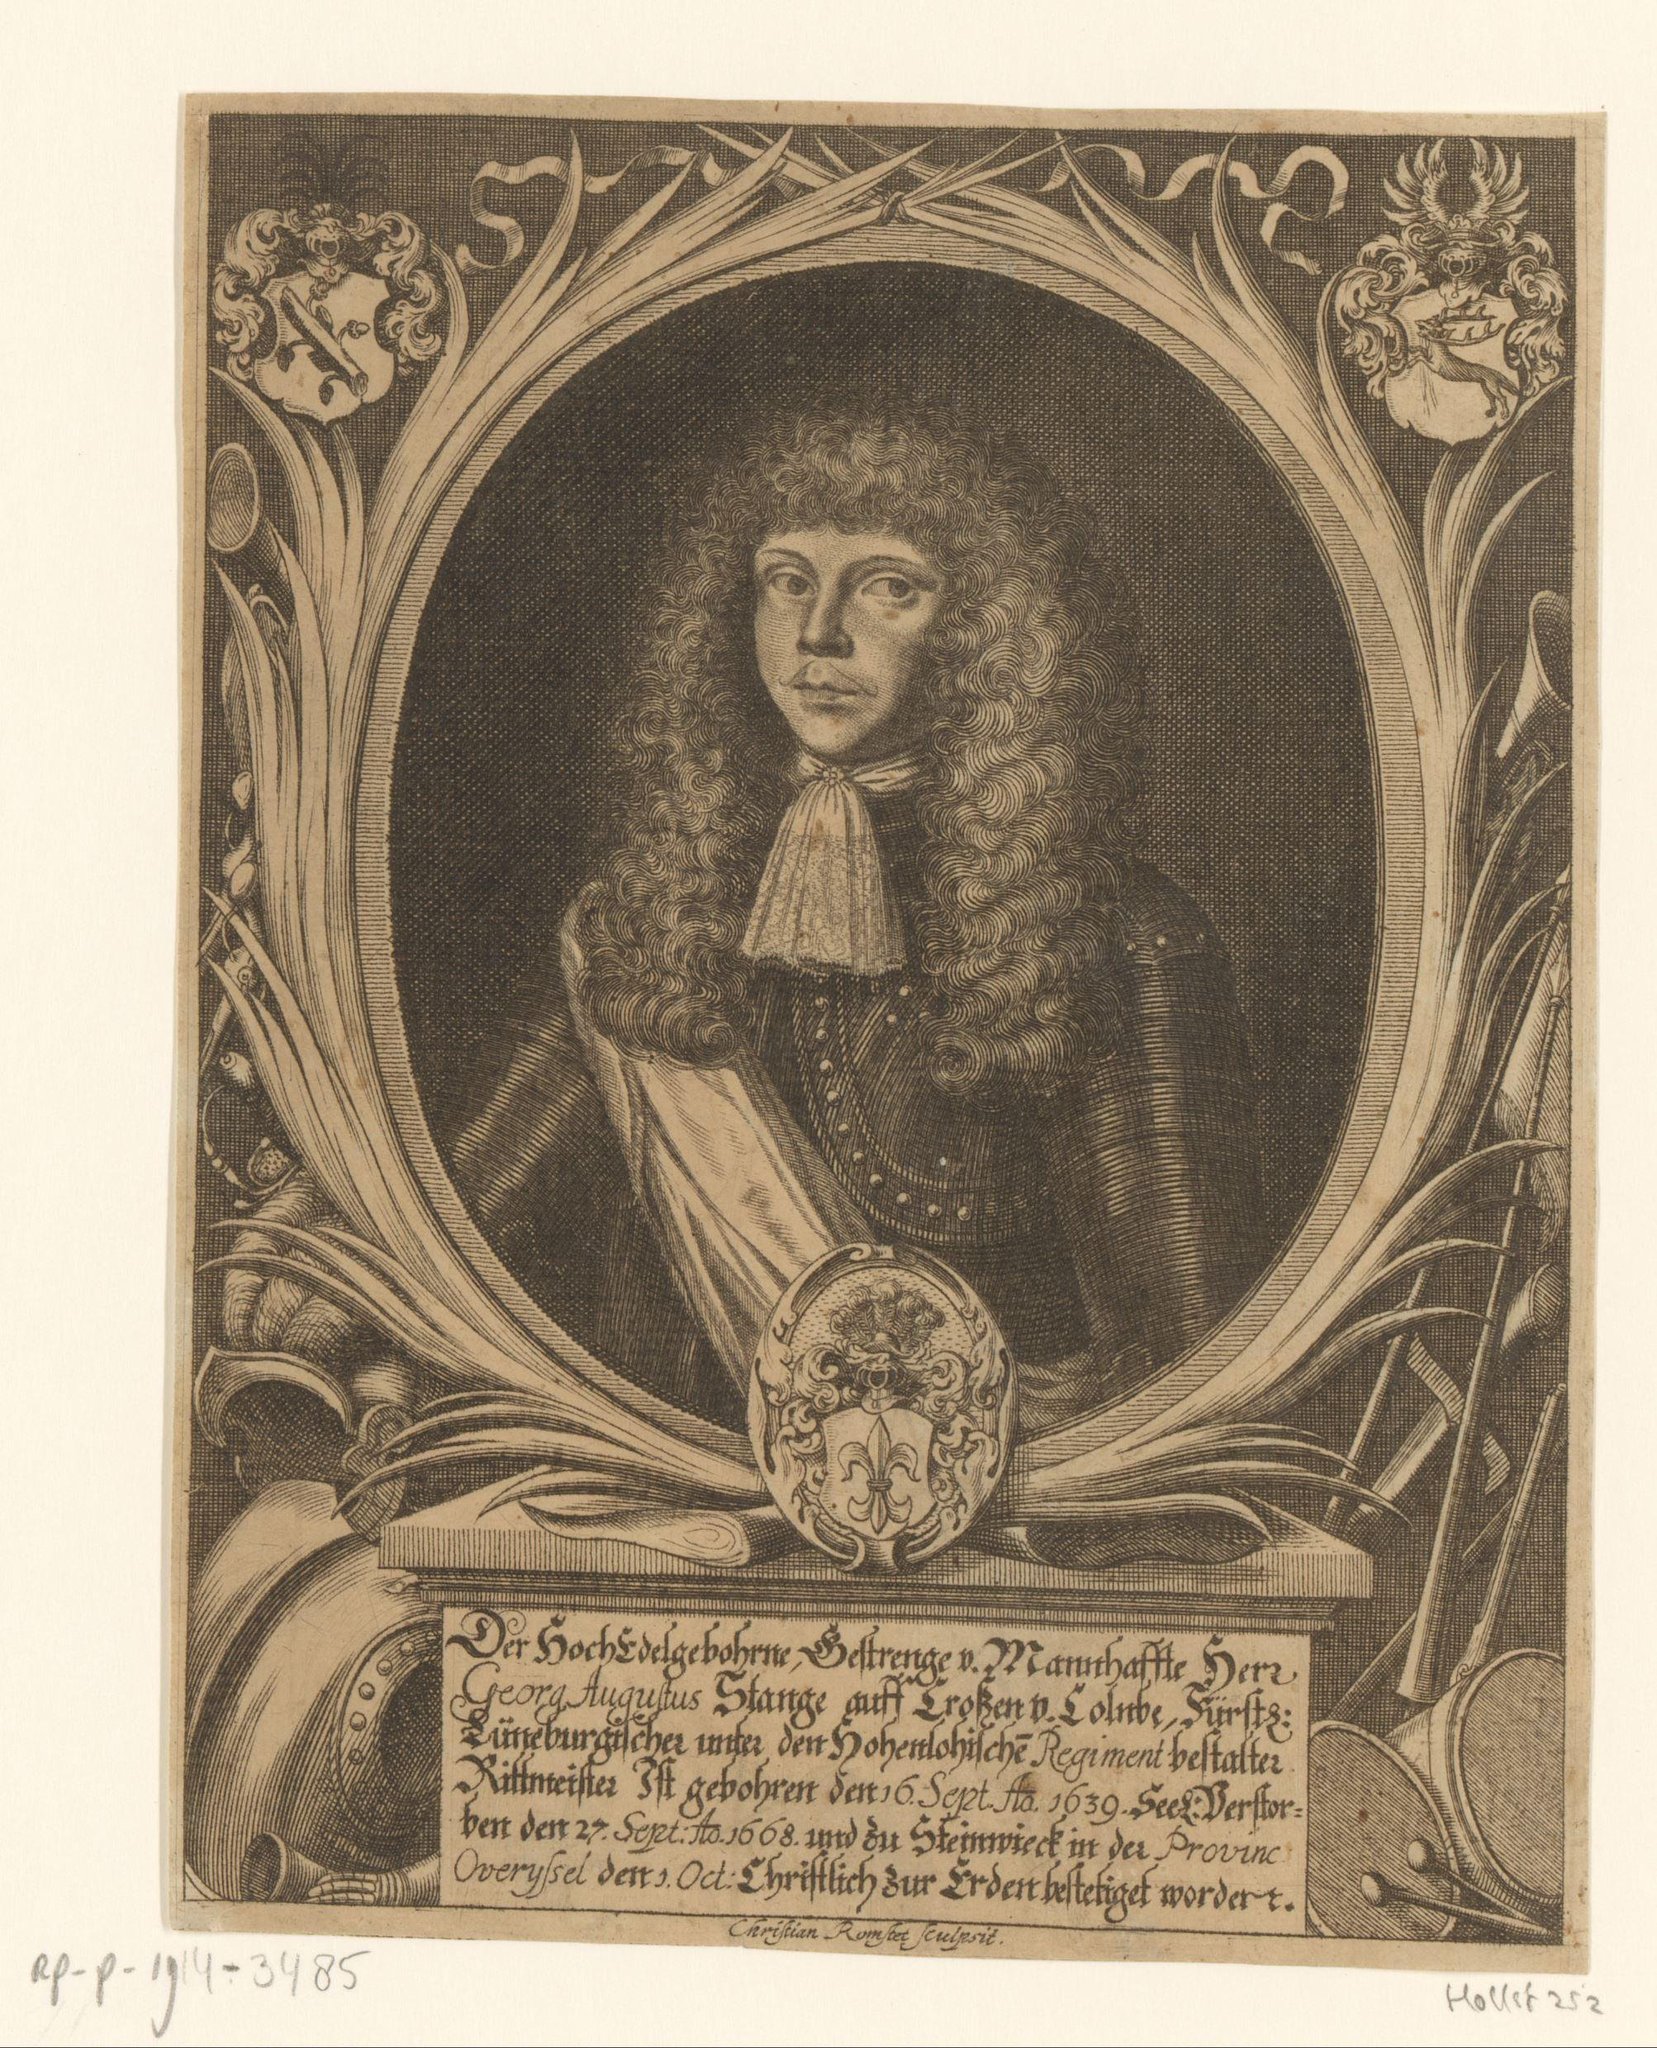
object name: print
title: Portret van Georg August von Stange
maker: christian romstet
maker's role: print maker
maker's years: 1640-1721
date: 1665-1721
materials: paper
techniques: engraving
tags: armour, historical persons, armorial bearing, heraldry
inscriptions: collector's mark: Lugt 2228